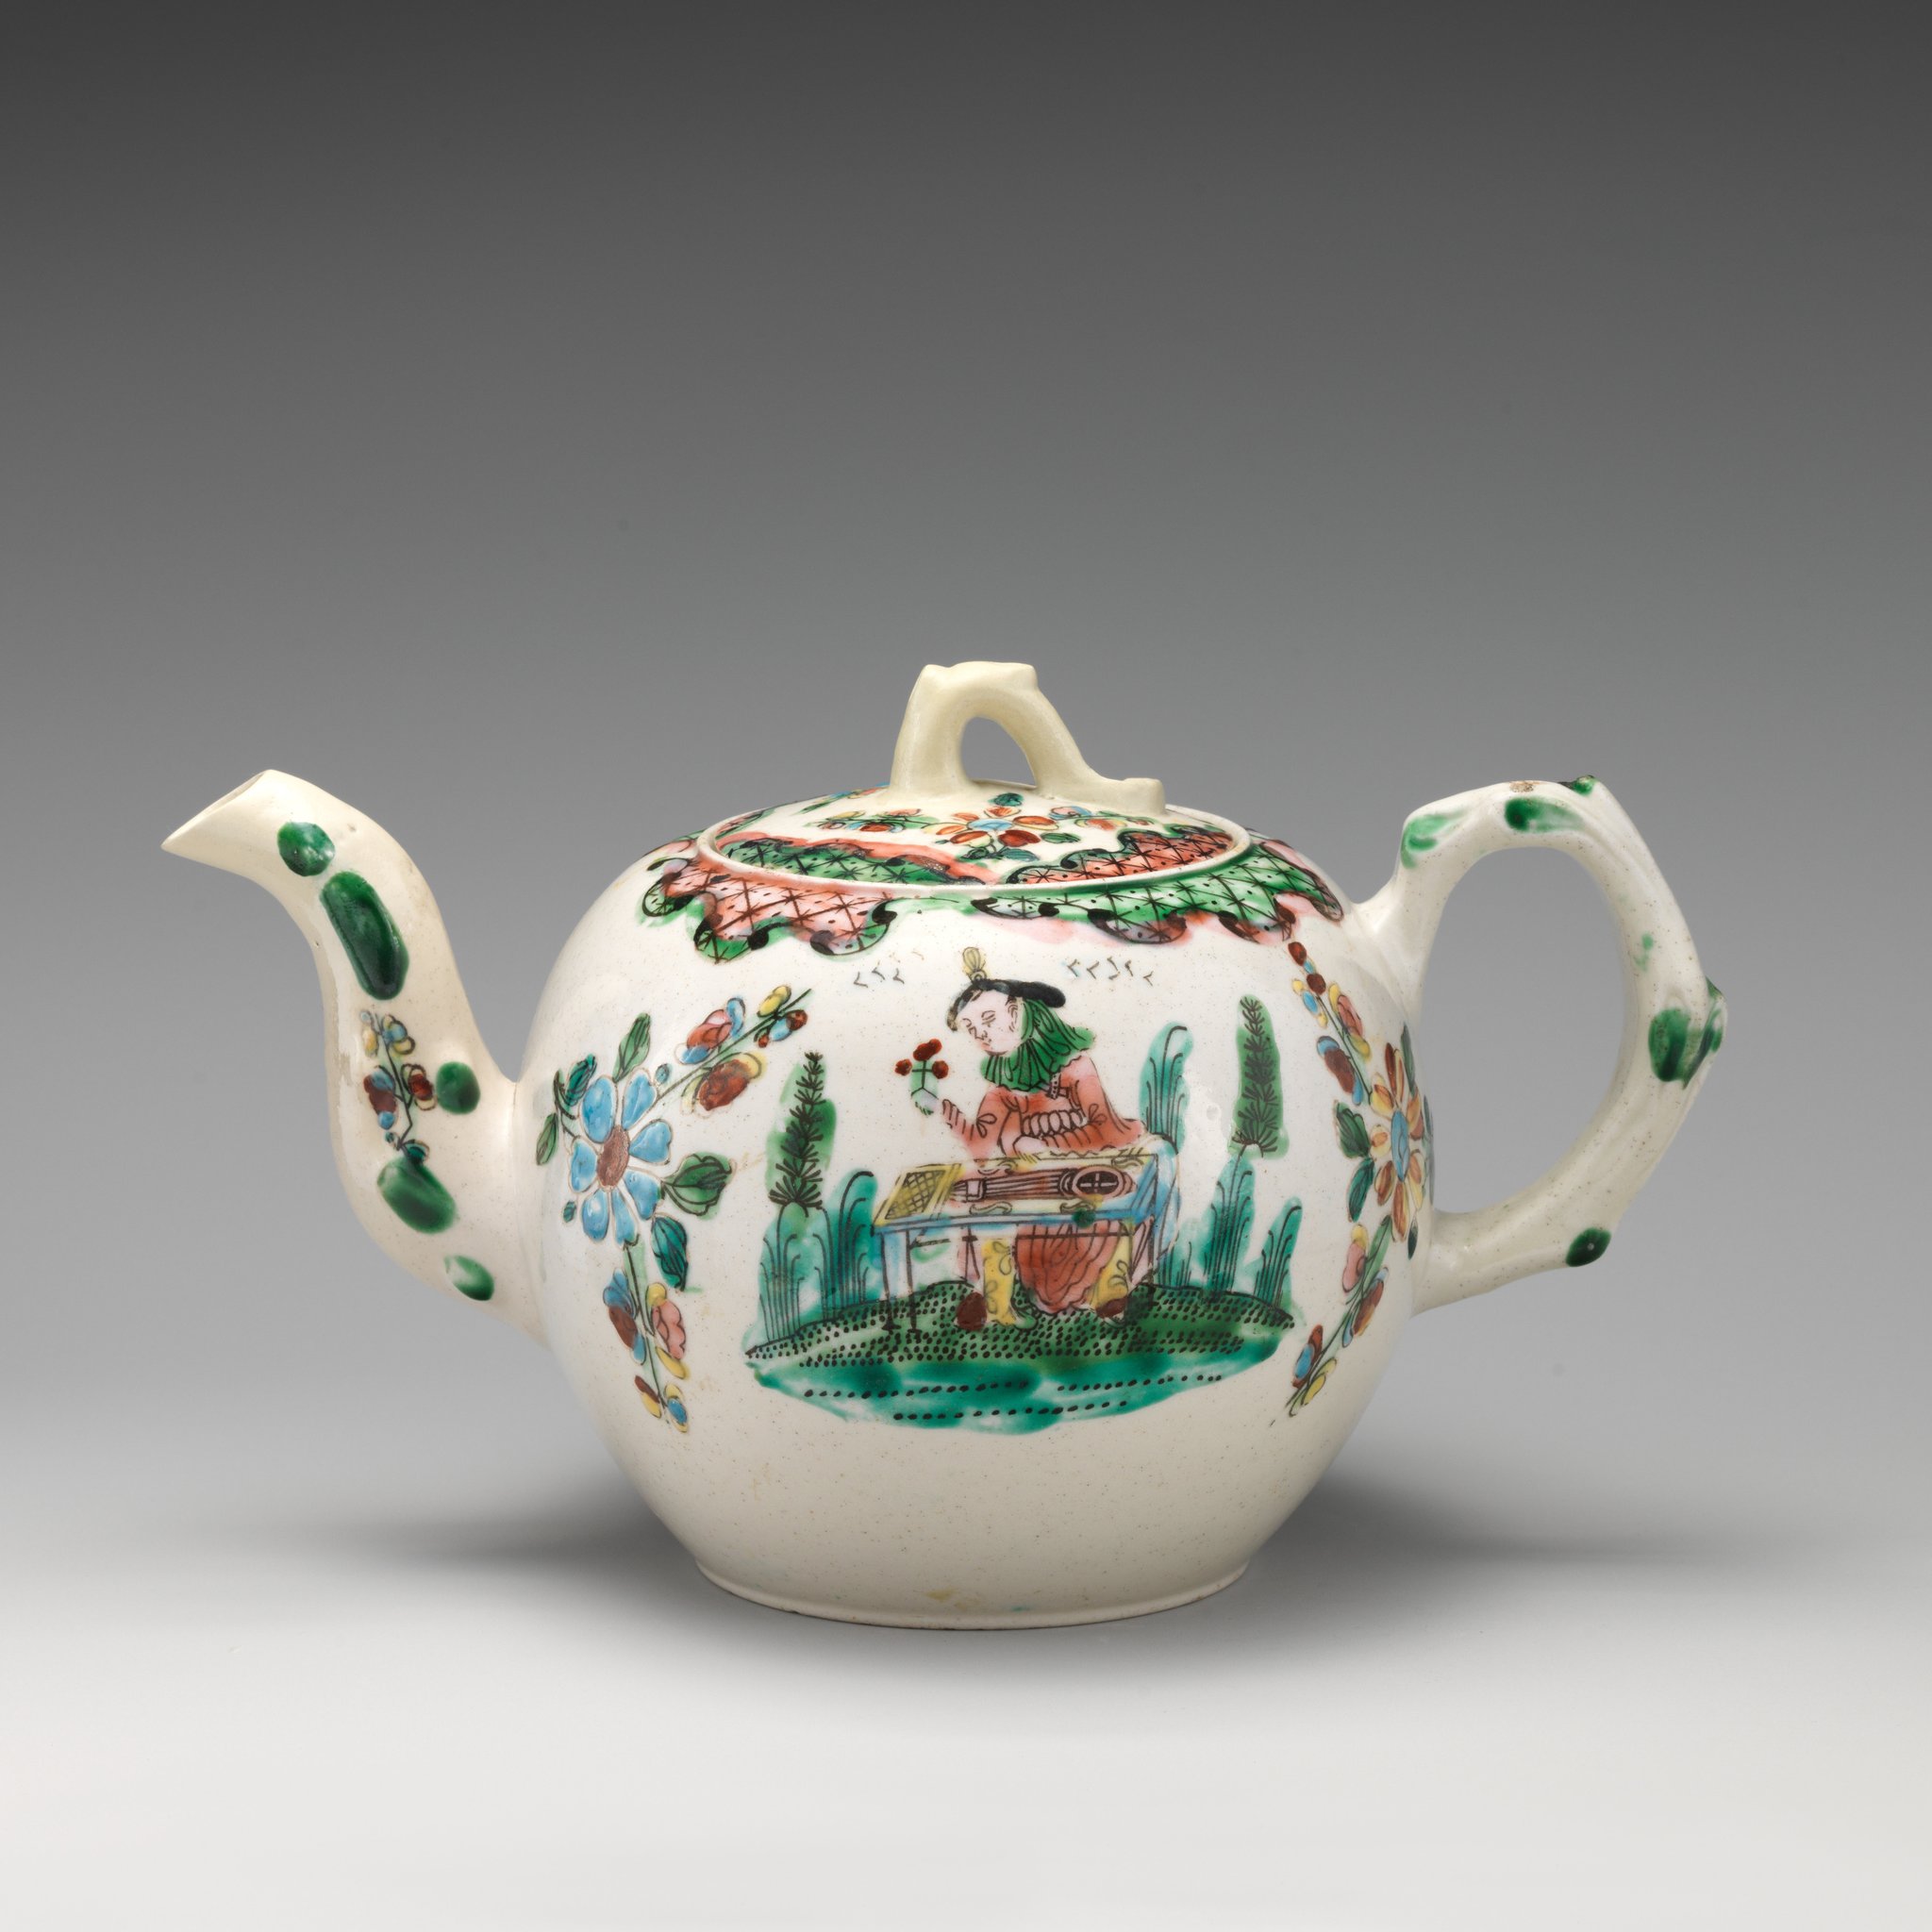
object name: teapot with cover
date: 1760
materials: stoneware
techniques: salt glaze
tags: human figures,flowers